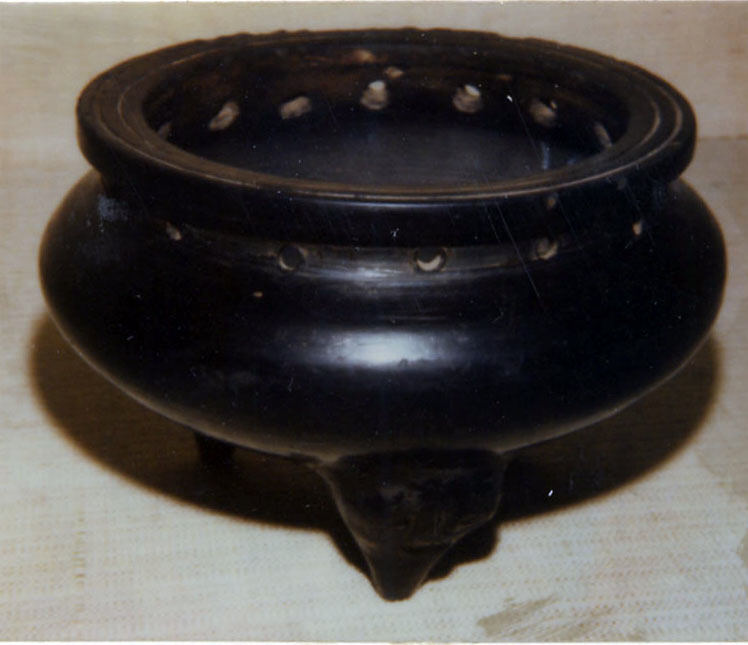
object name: tripod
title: Tripod (Ding)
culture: chinese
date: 1801-2000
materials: earthenware